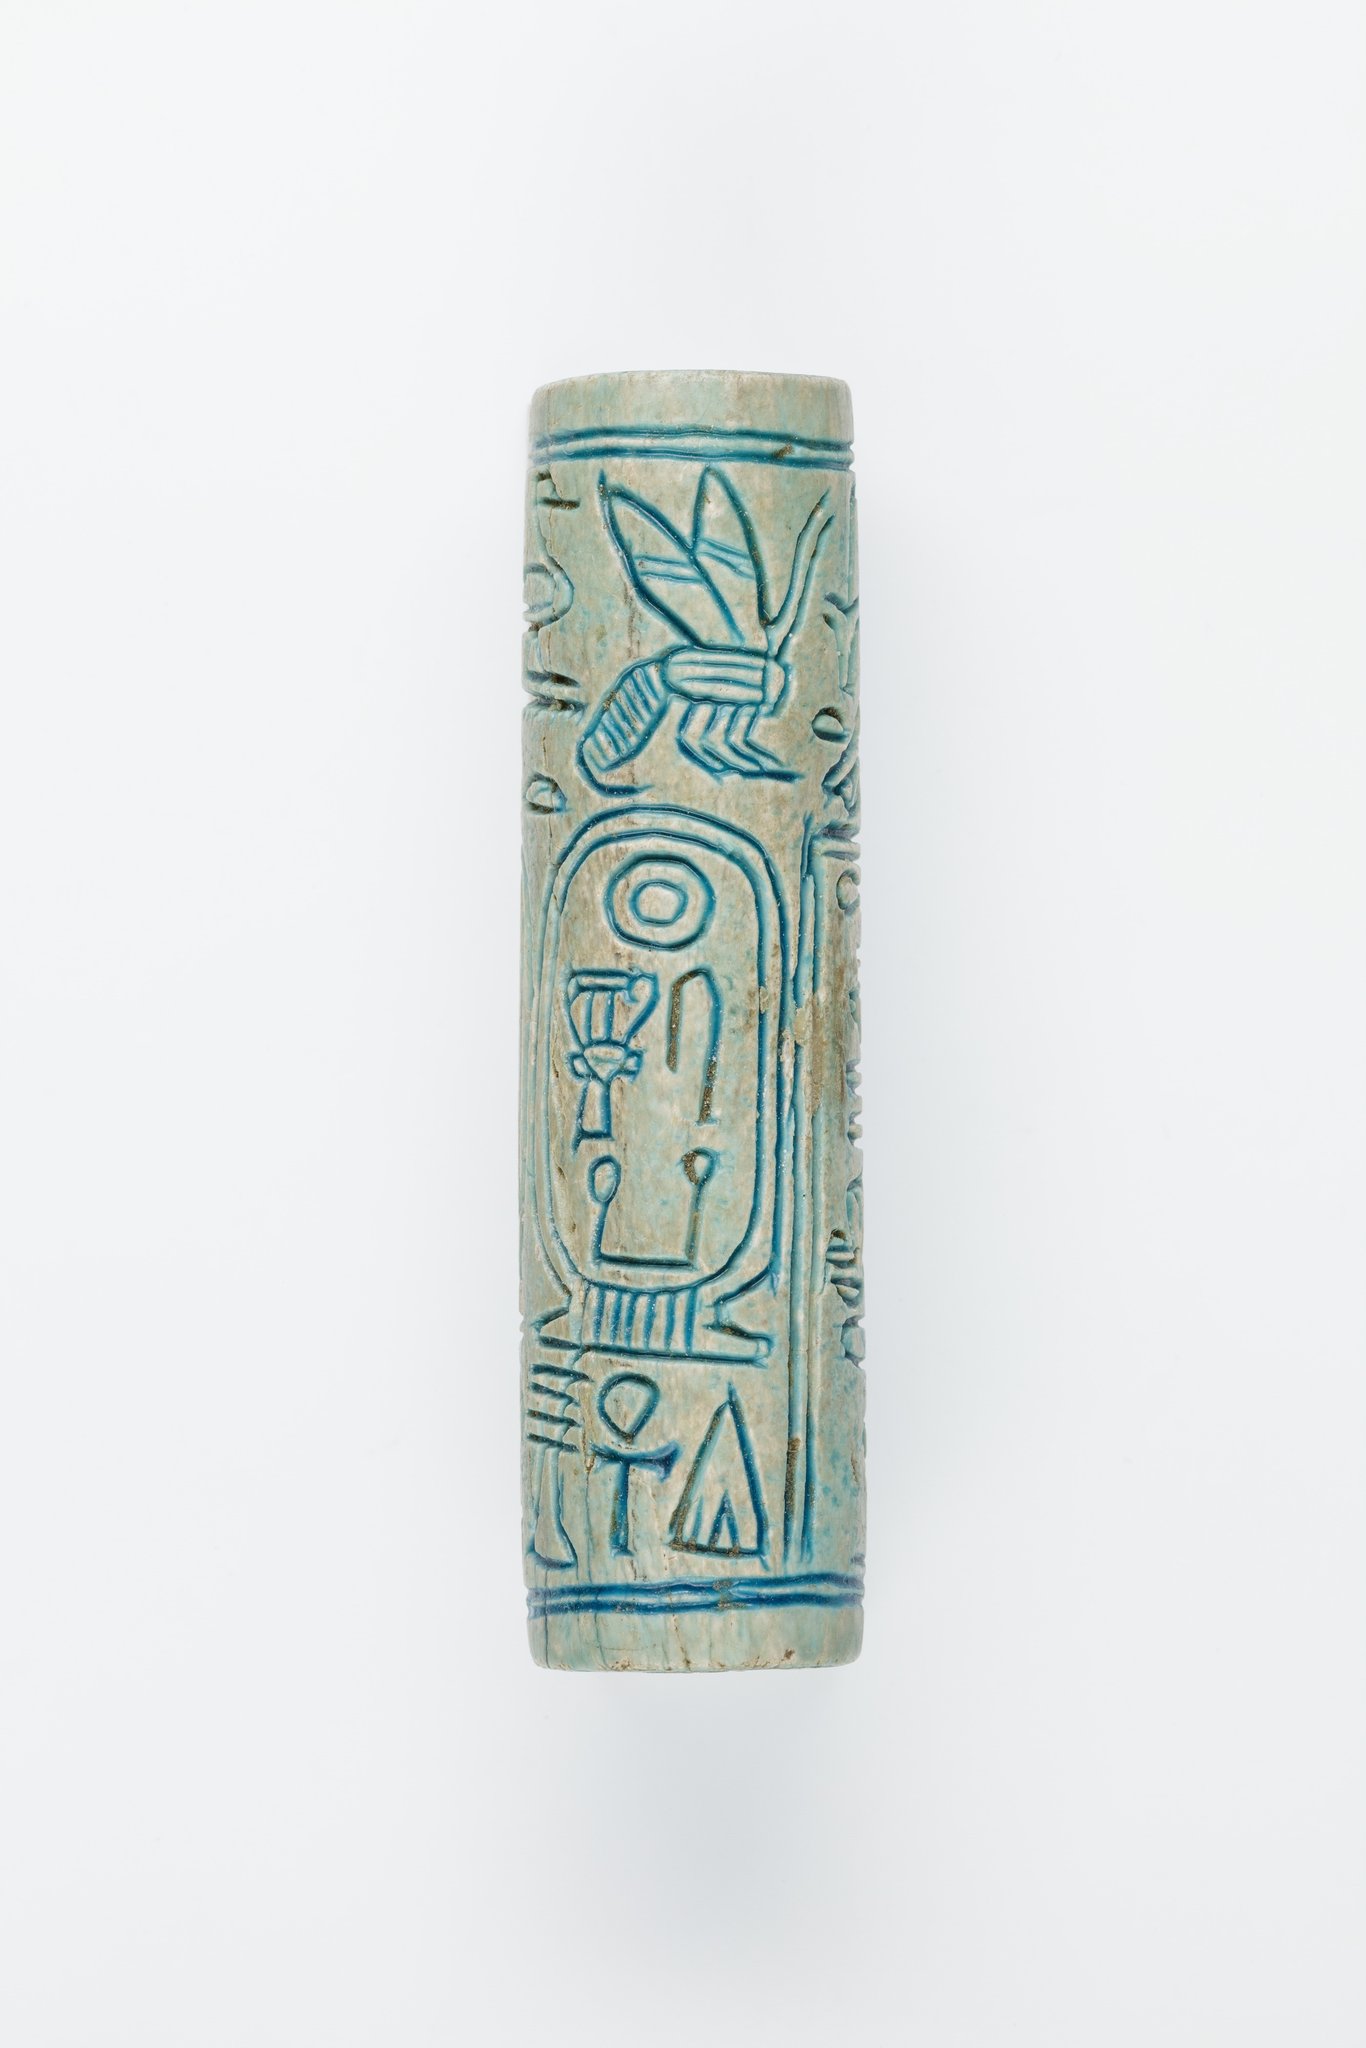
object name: cylinder seal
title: Cylinder Seal of Amenemhat Senbef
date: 1799-1795 BCE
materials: stone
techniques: glazing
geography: southern upper egypt